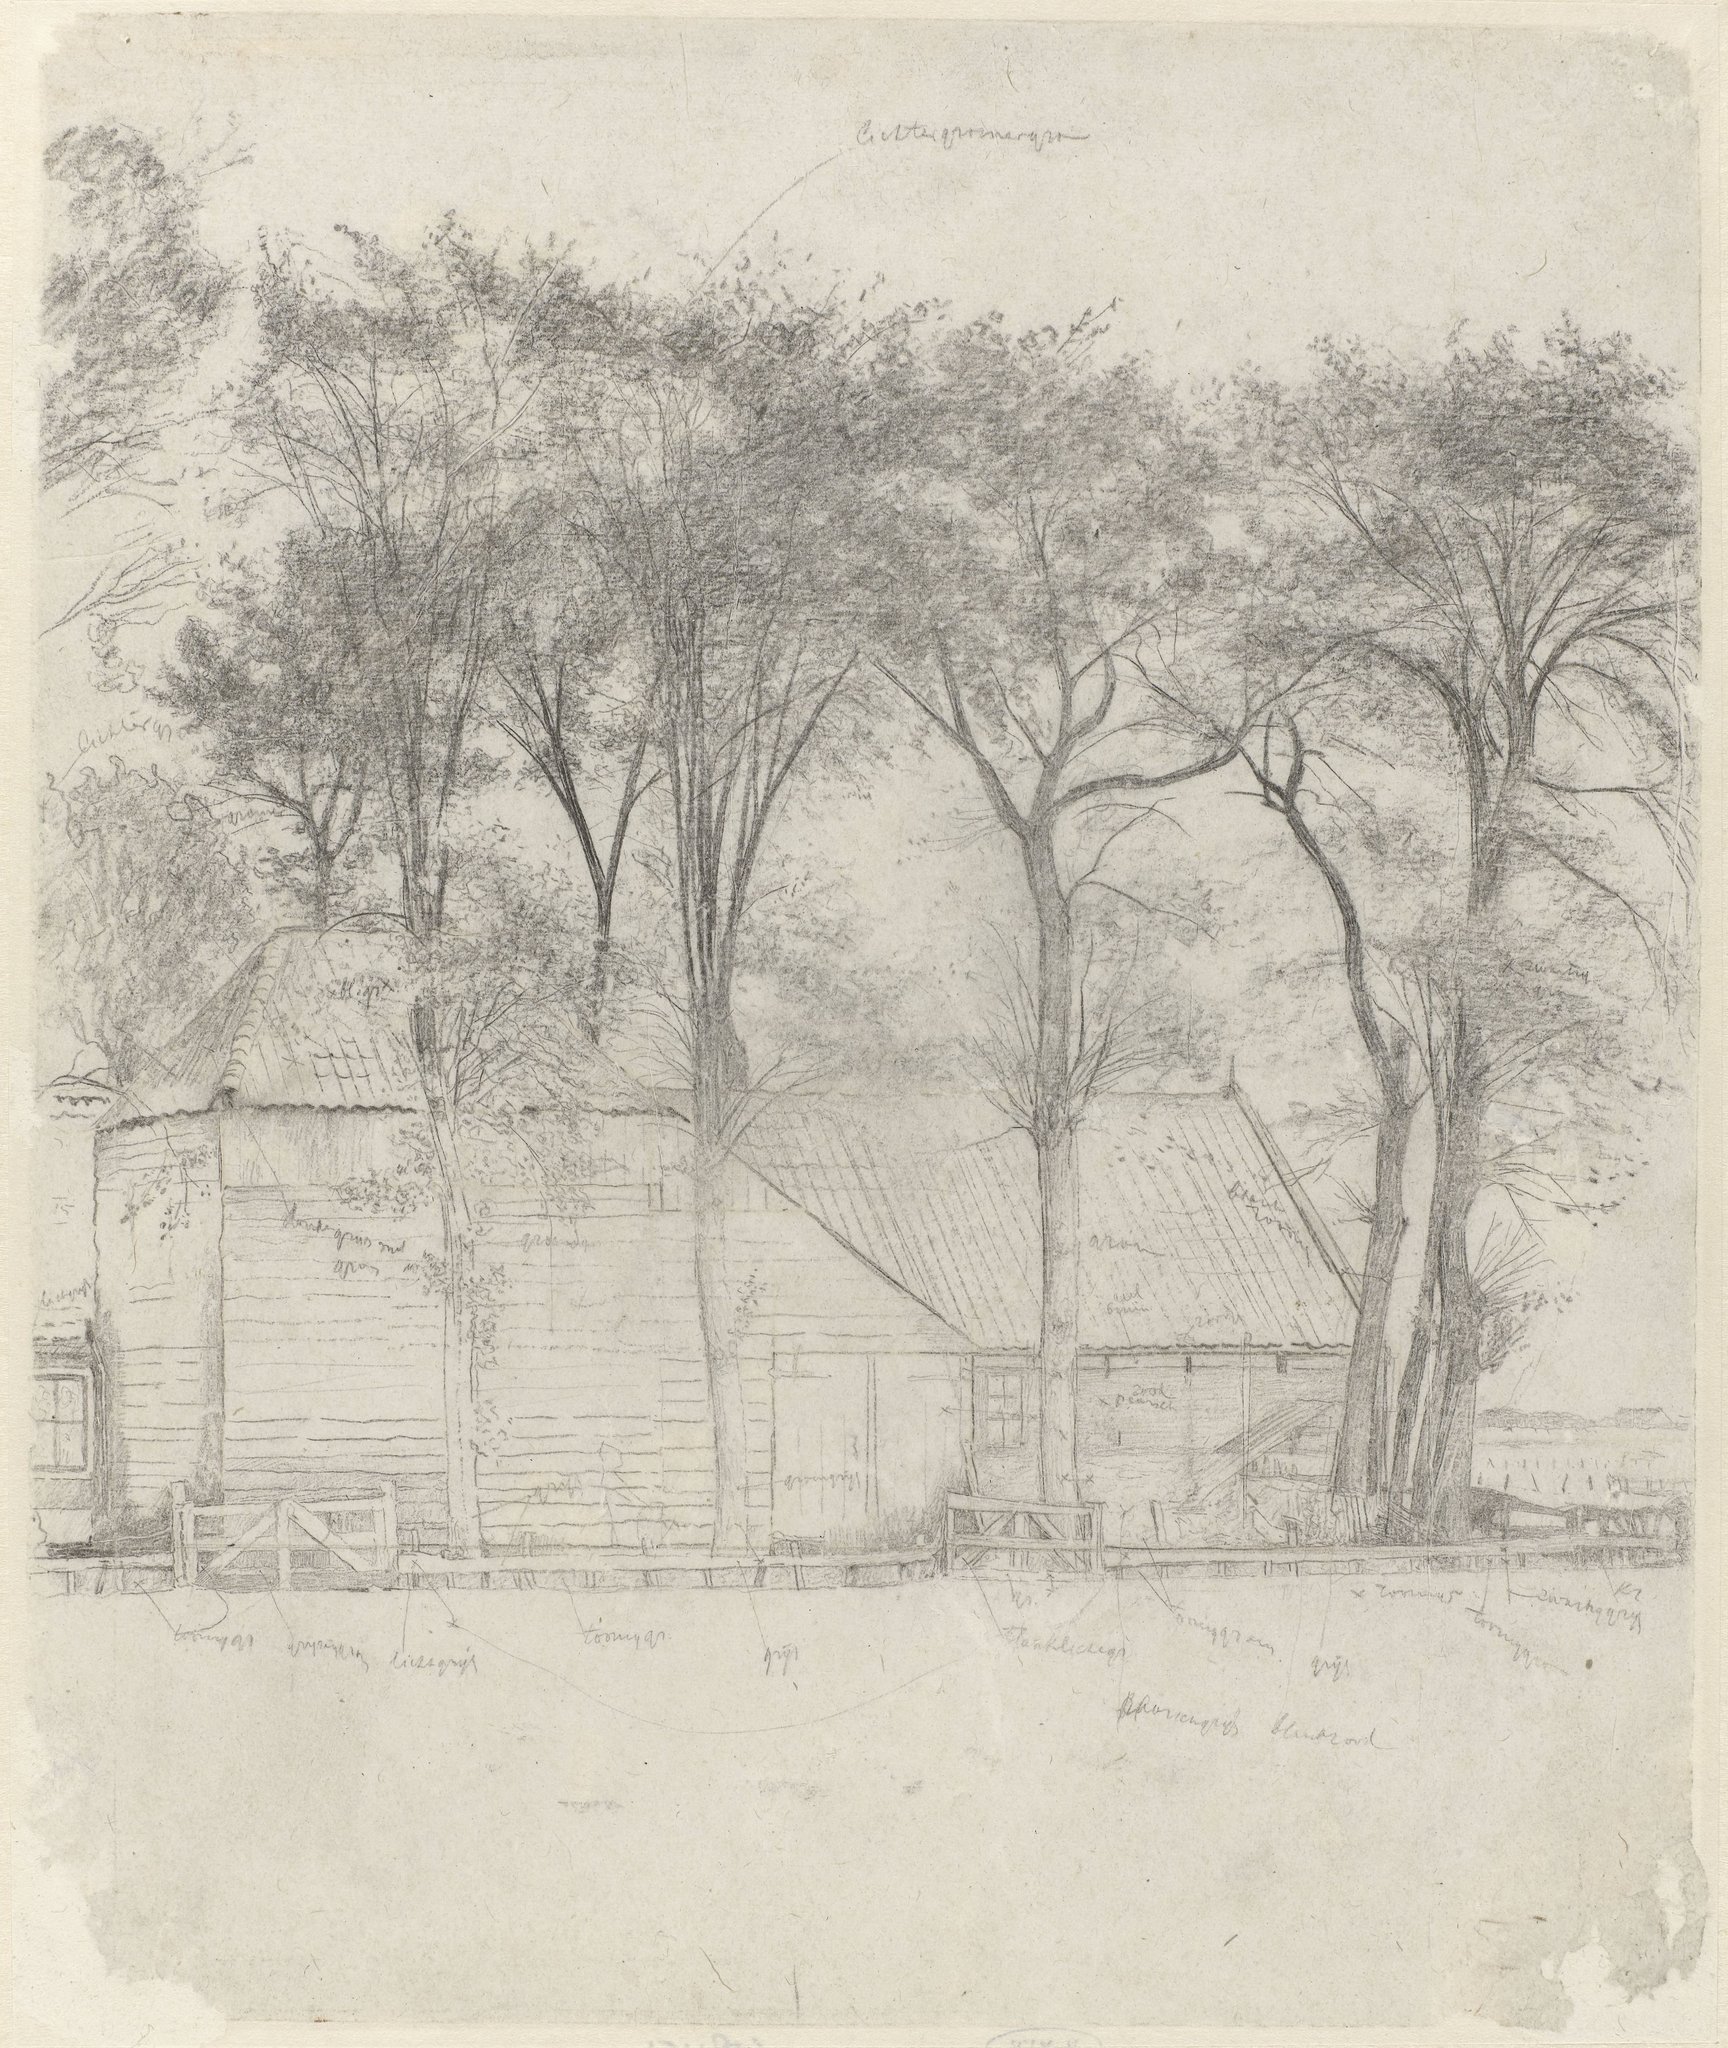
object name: drawing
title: Boerderij bij Velzen: de twee schuren van opzij gezien, omgeven door hoge bomen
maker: gerrit willem dijsselhof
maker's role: designer, draughtsman, print maker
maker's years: 1866-1924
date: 1876-1924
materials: chalk, paper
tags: farm (building)